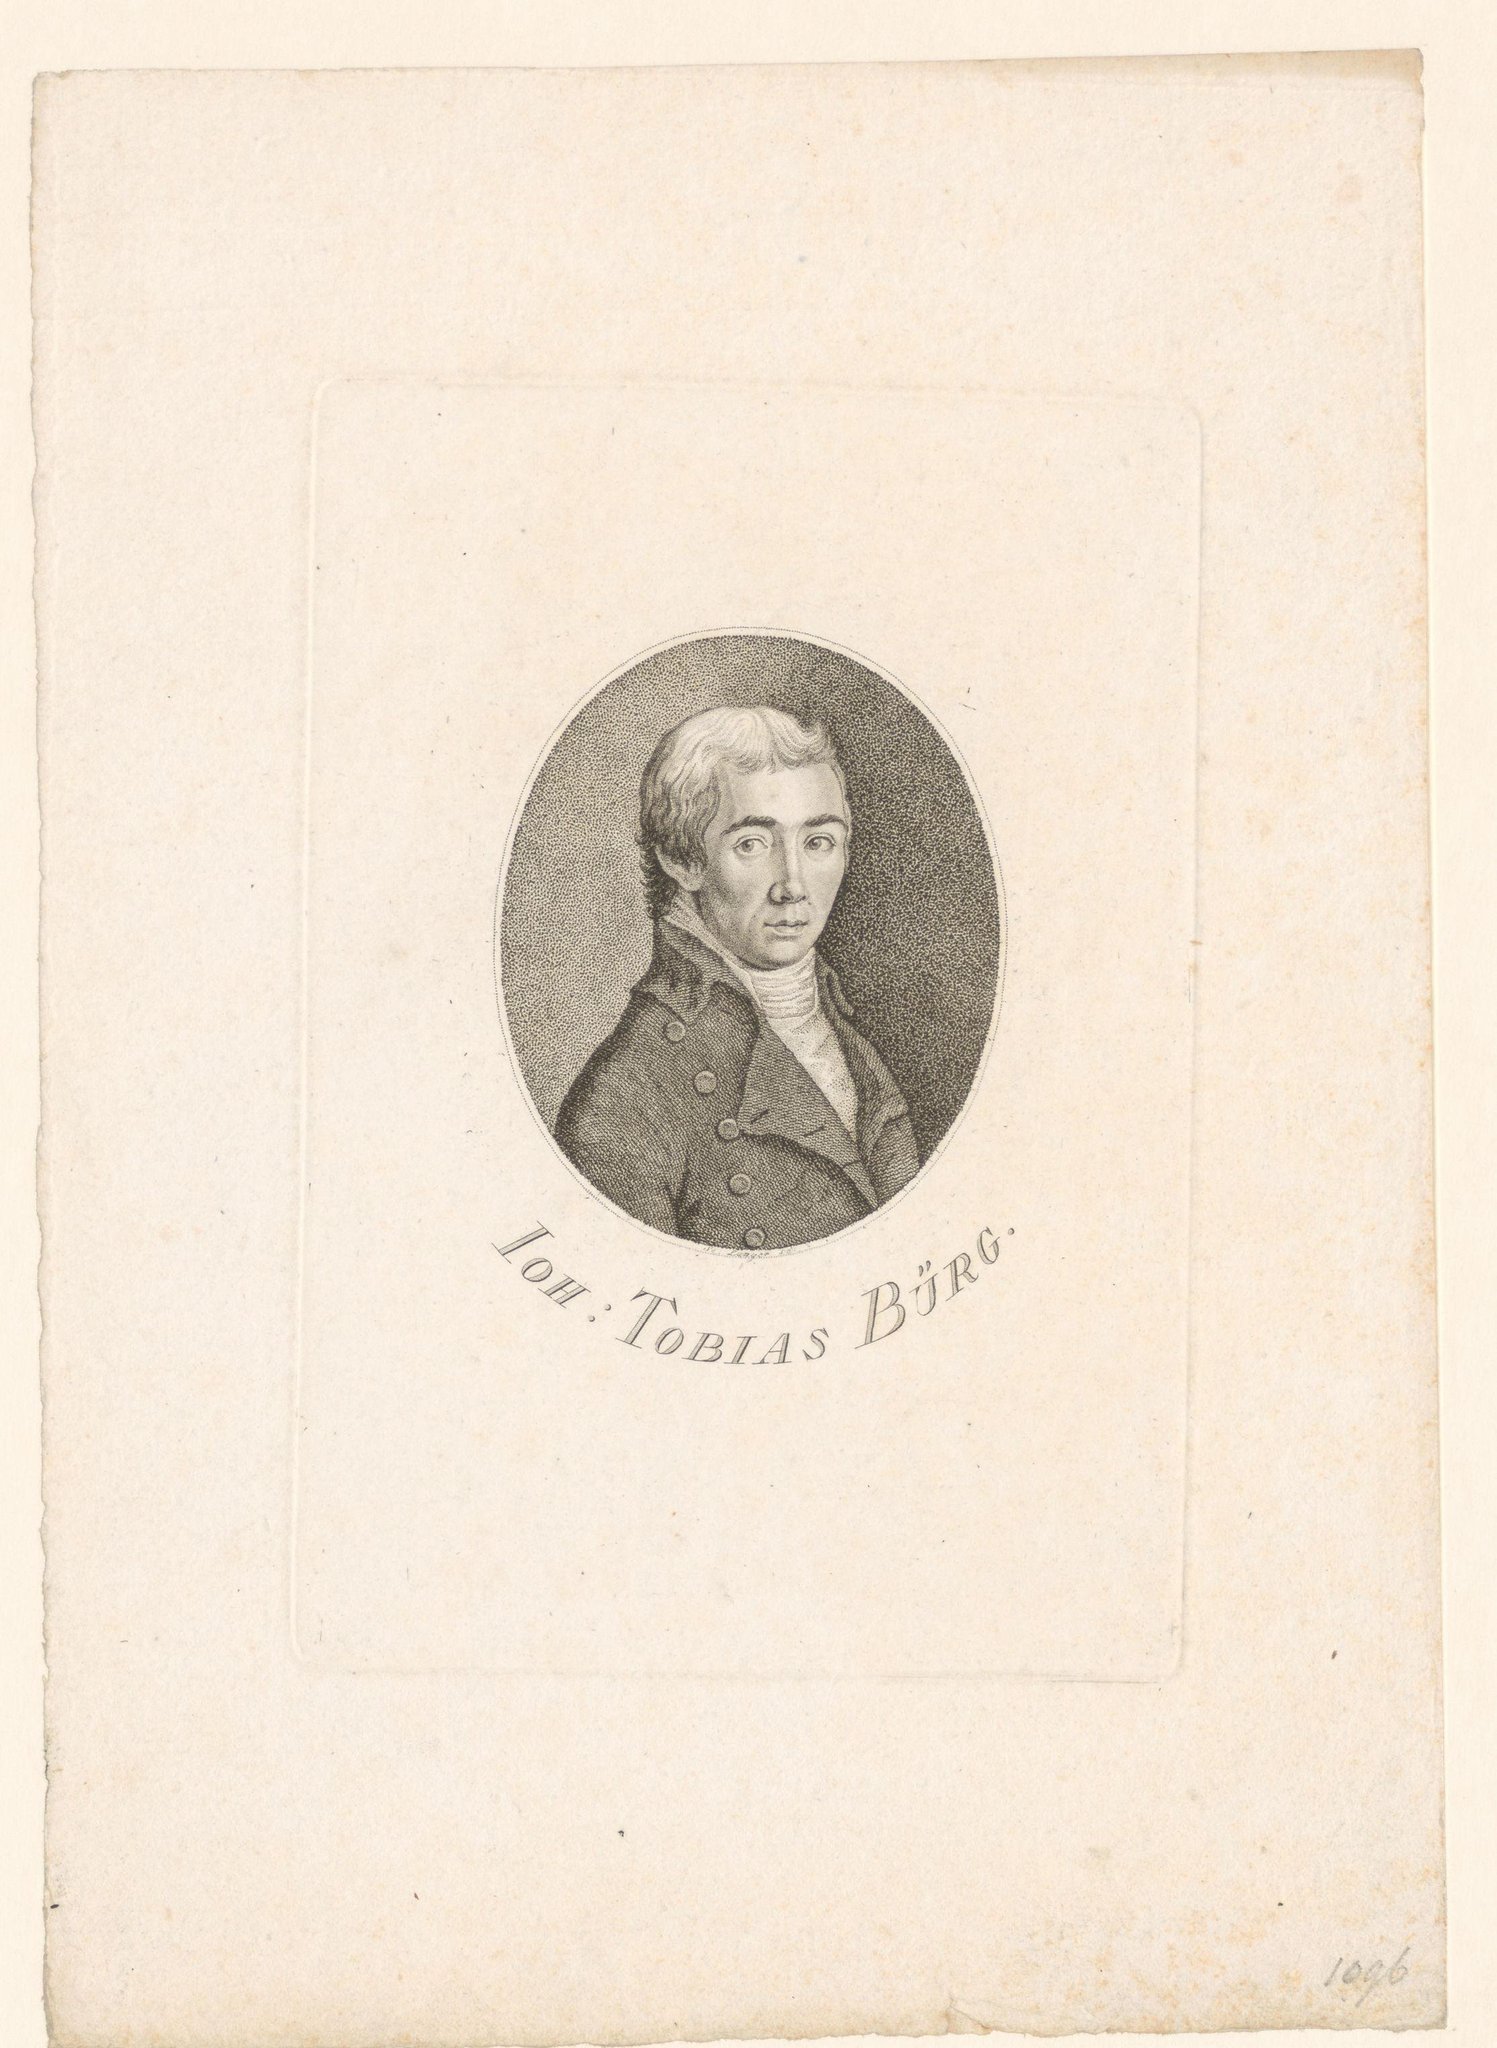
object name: print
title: Portret van Johann Tobias Bürg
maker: sebastian langer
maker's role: print maker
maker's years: 1772-1841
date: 1782-1841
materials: paper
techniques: stippling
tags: vienna, physicist, astronomy (and cosmography) (+ portrait of scholar, scientist), physics and mechanics (+ portrait of scholar, scientist), historical persons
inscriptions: collector's mark: Lugt 2228